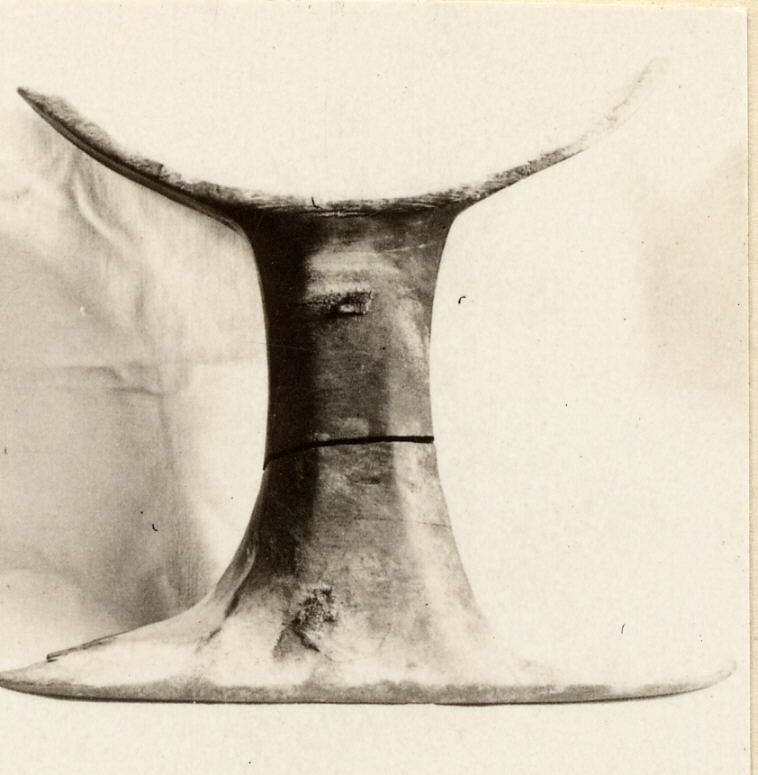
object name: headrest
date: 2030-1640 BCE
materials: wood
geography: egypt